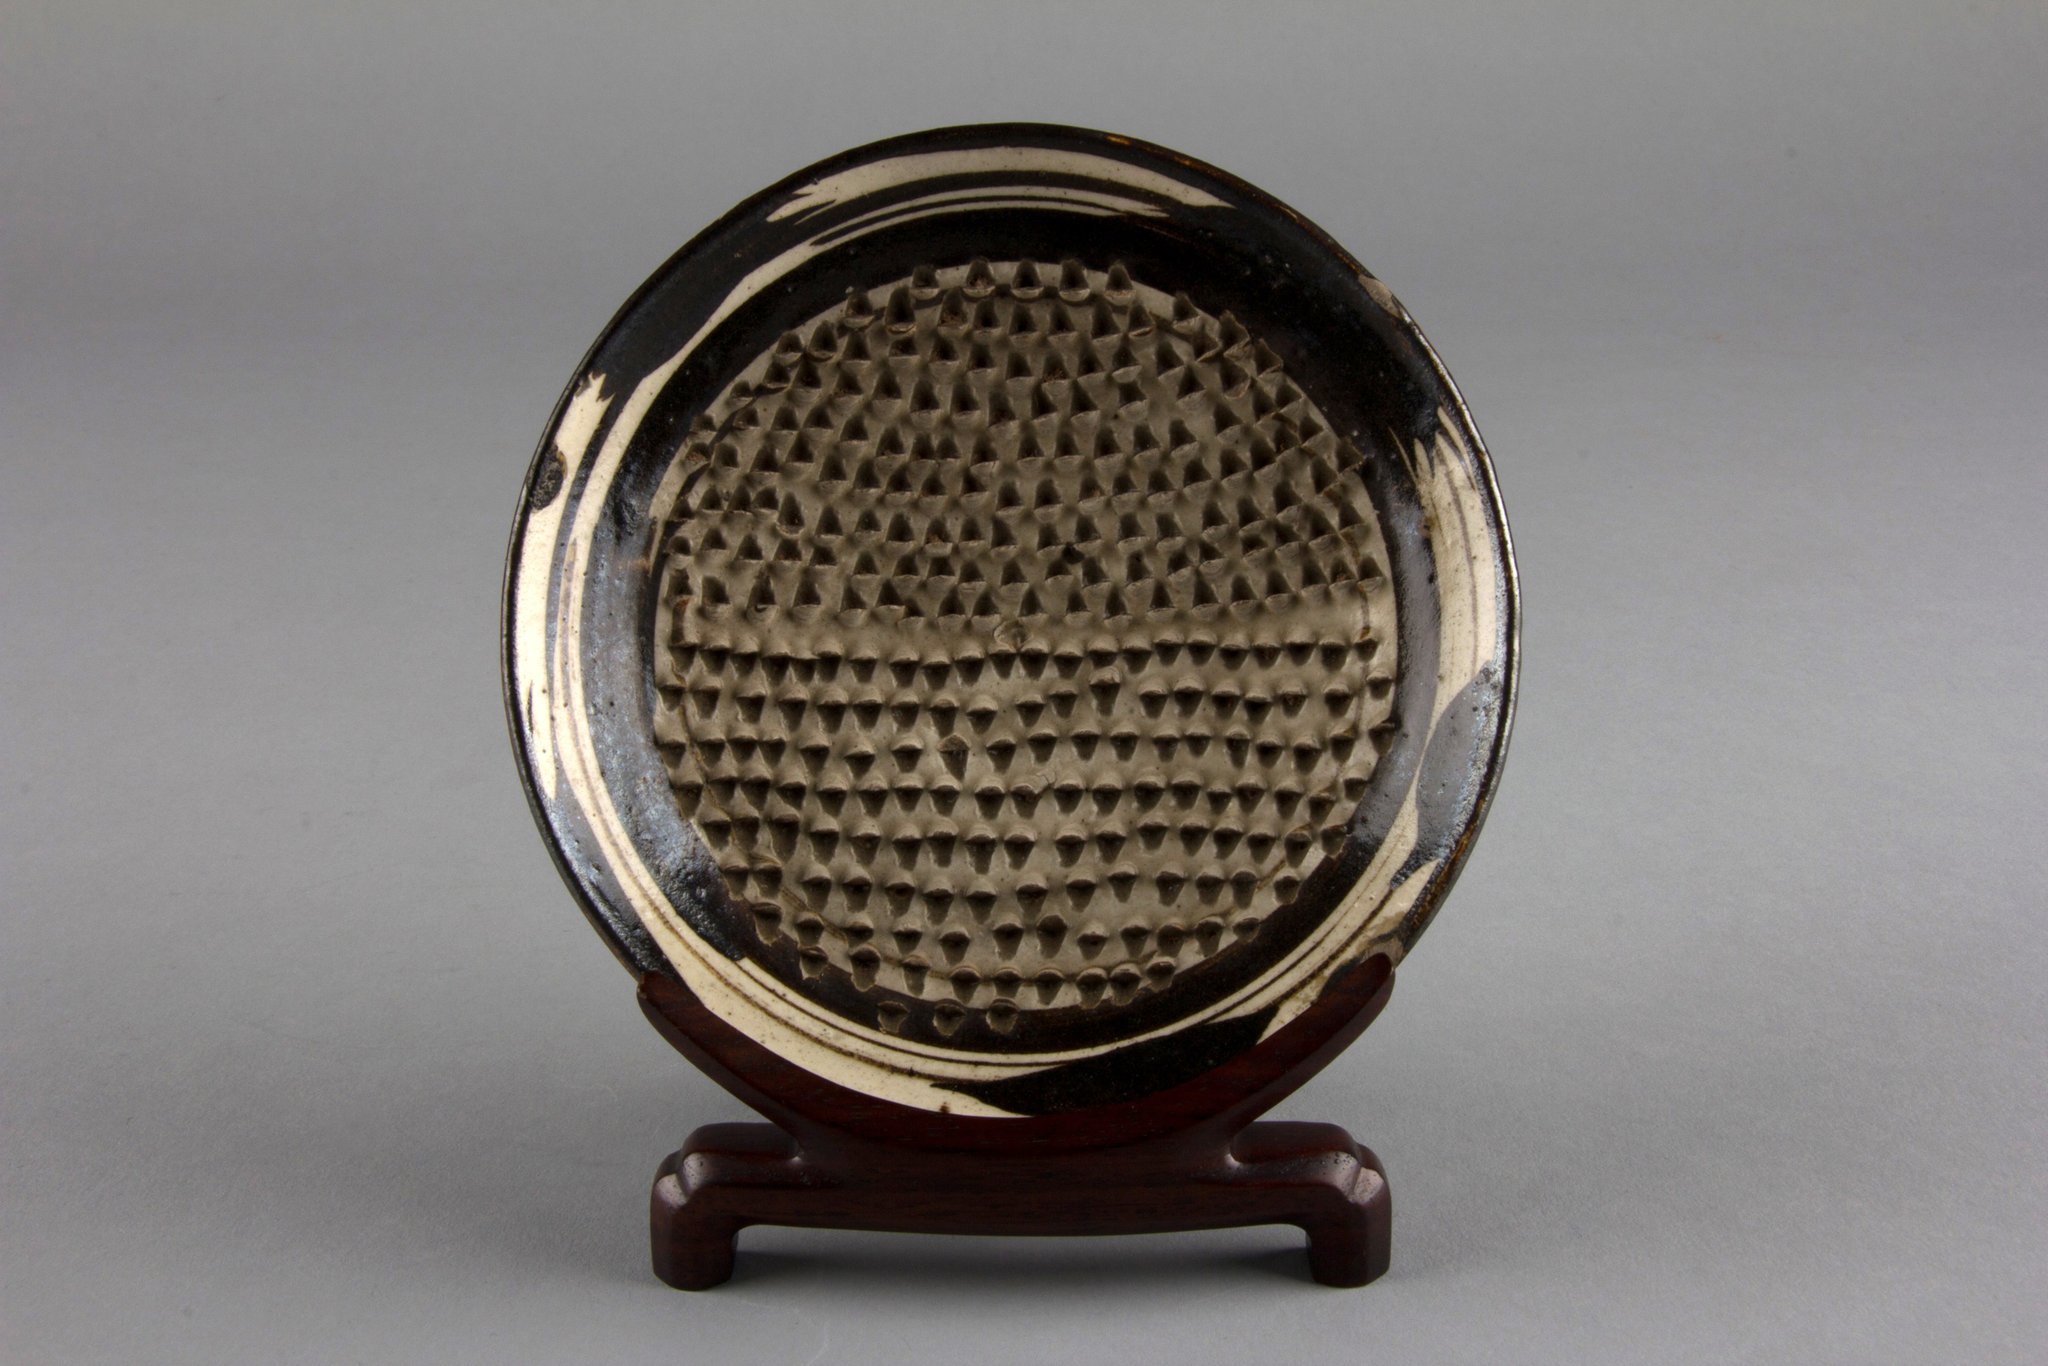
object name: dish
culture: chinese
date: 960-1279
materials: stoneware